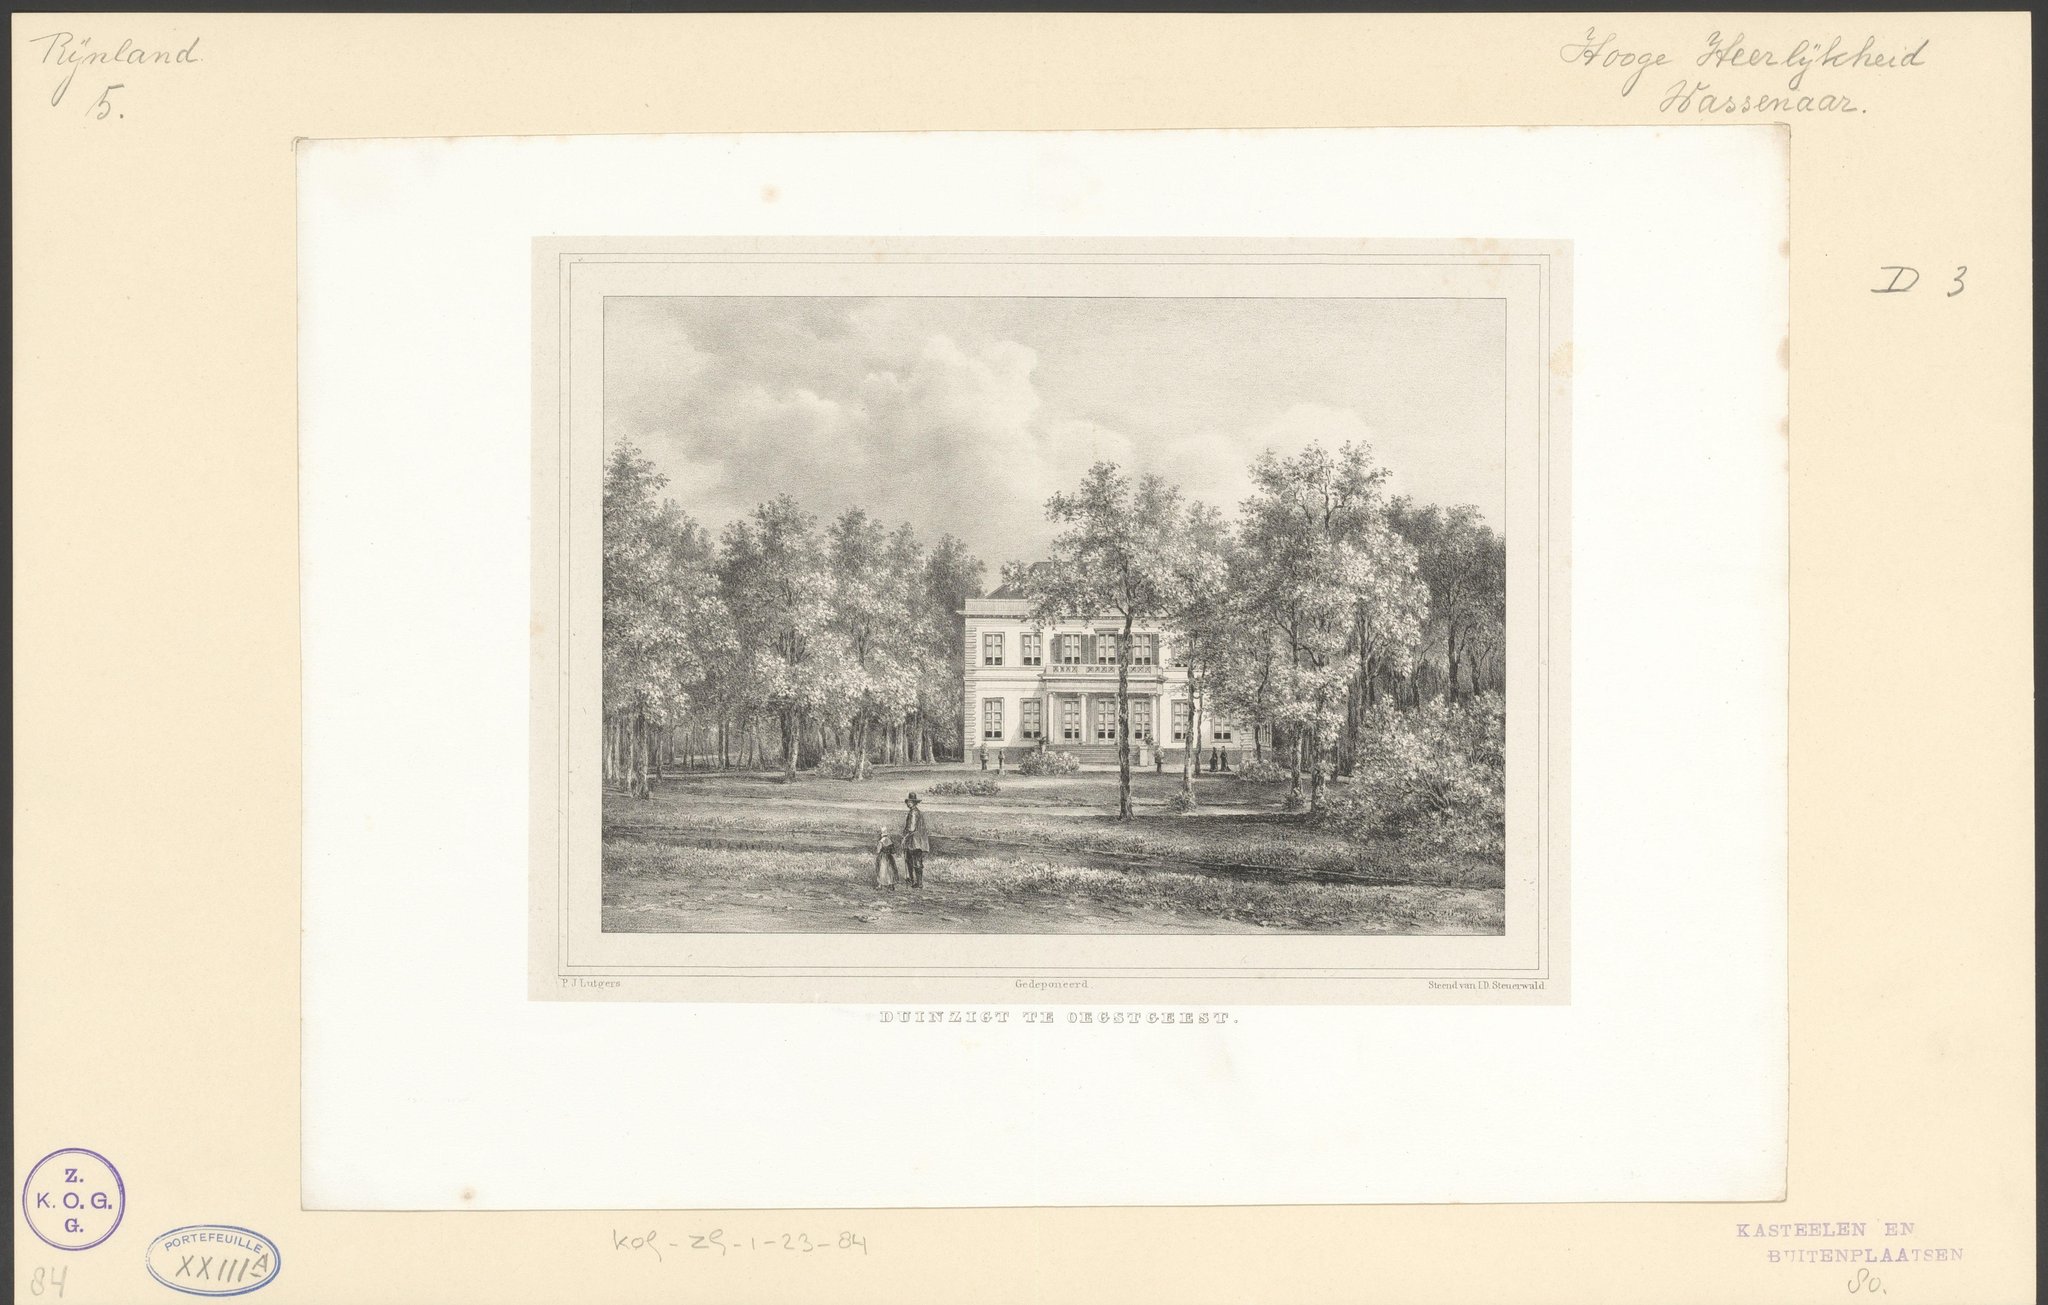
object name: print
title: Duinzigt te Oestgeest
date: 1855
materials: paper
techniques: lithograph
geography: the hague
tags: trees, farm or solitary house in landscape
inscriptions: : ‘Gedeponeerd’, stamp, stamp, collector's mark: Lugt 1641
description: Onderwerpsrubrieken binnen de Atlas Zeden en Gewoonten: Zeden en Gewoonten in Engeren Zin, De Woning. Kastelen en buitenplaatsen. Holland.